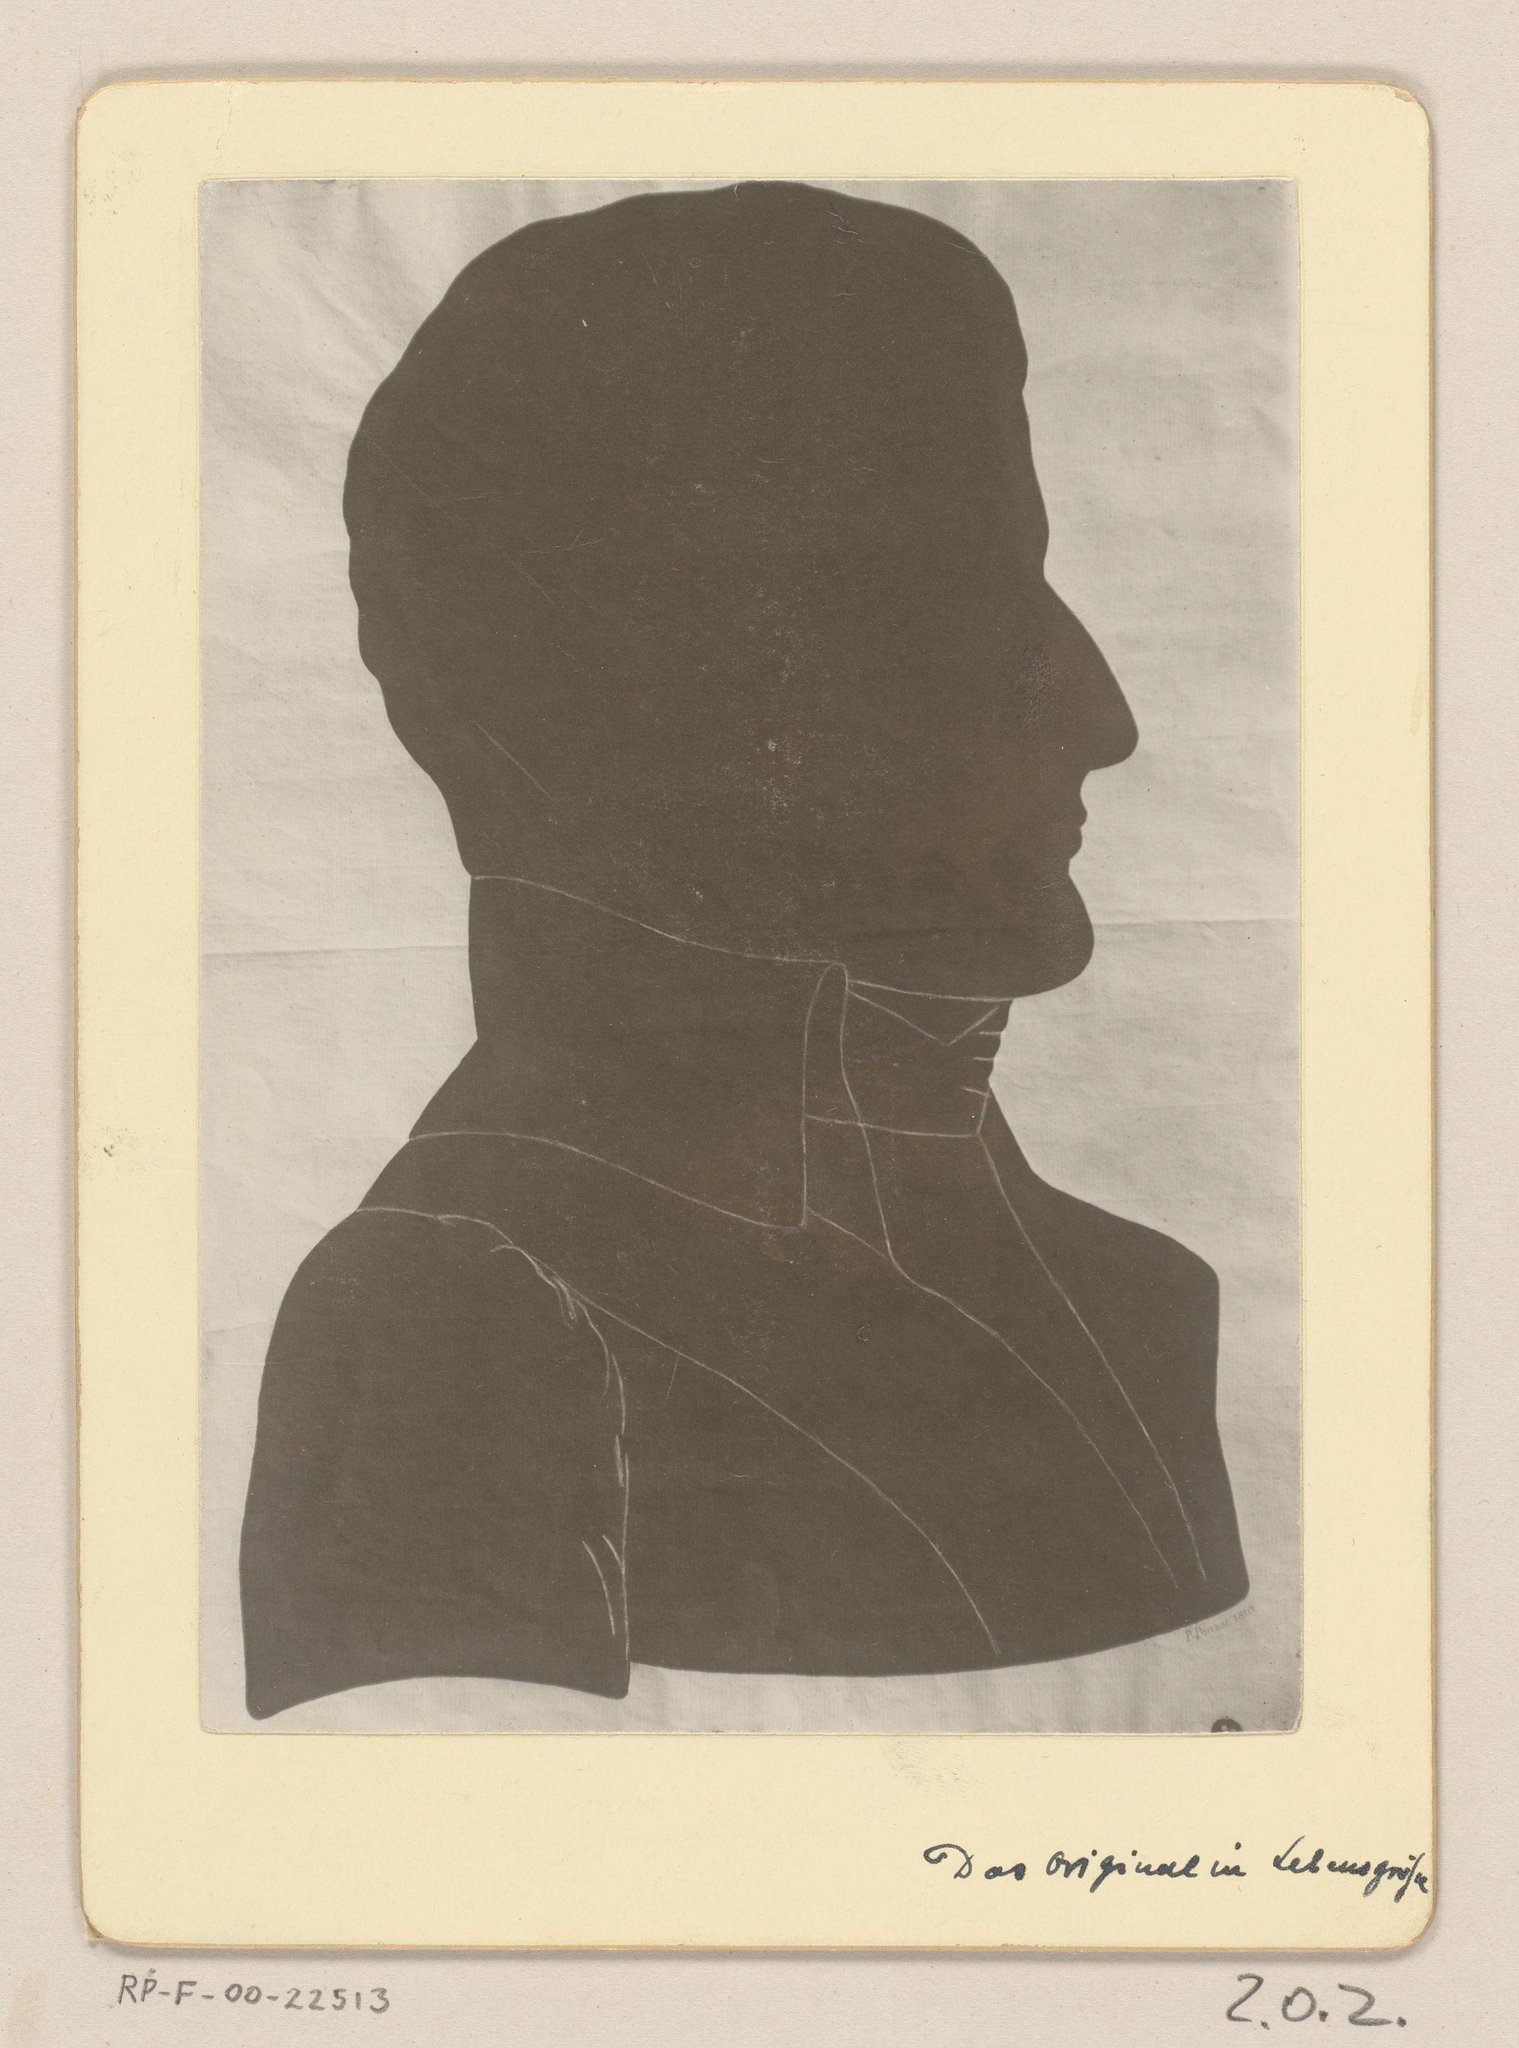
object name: photograph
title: Fotoreproductie van een getekend silhouetportret van Napoleon Bonaparte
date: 1890-1908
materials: paper, cardboard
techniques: gelatin silver print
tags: napoleon i (emperor of the french), historical persons, emperor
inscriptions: inscription: ‘Zie brief van Wolfgang Goetz./ 20 Juni 1908’, inscription: ‘Das Original in Lebensgrösse’